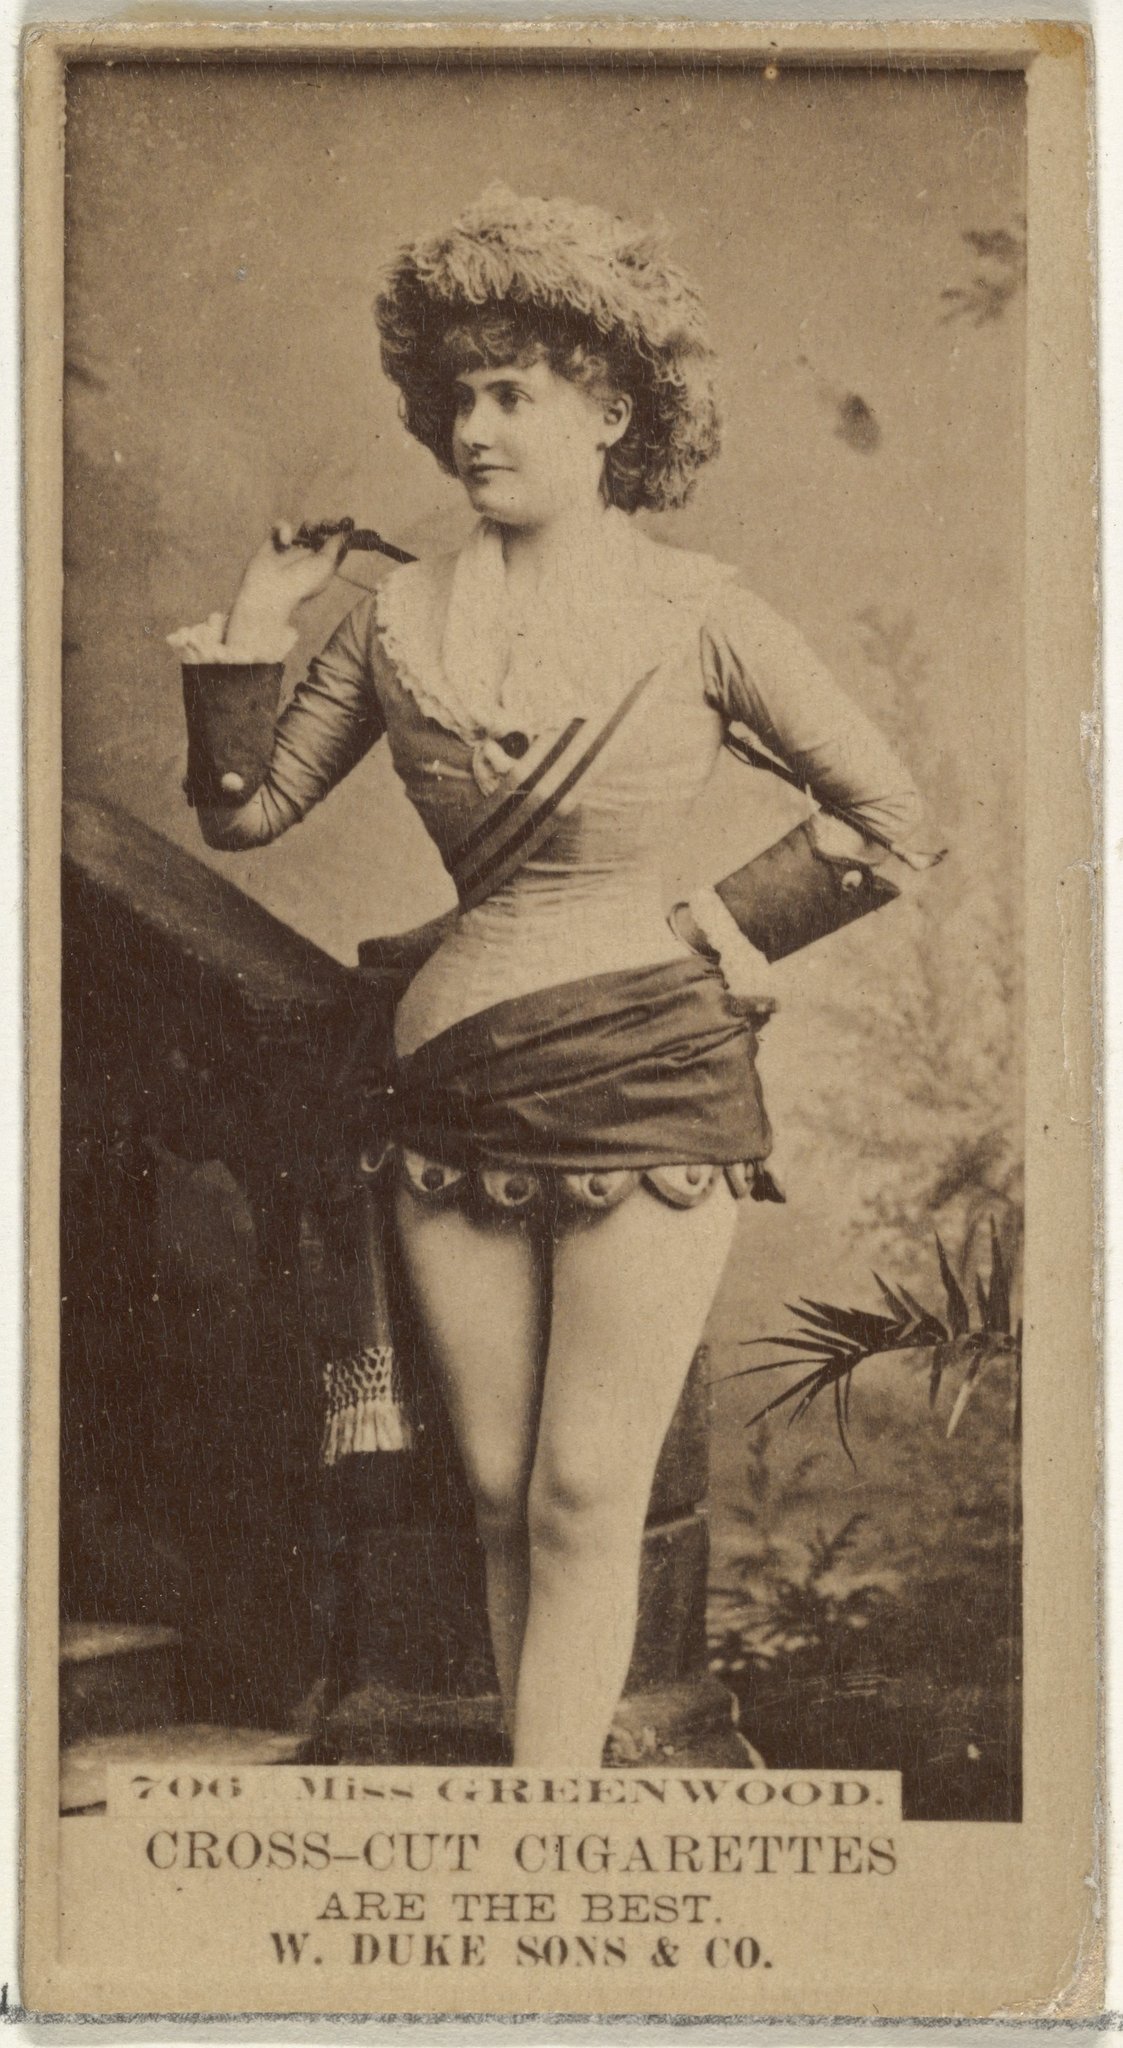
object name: photograph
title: Card Number 706, Miss Greenwood, from the Actors and Actresses series (N145-3) issued by Duke Sons & Co. to promote Cross Cut Cigarettes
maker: w. duke, sons & co.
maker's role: publisher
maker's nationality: american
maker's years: 1870-1920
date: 1880-1889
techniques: albumen silver print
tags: portraits,women,actresses